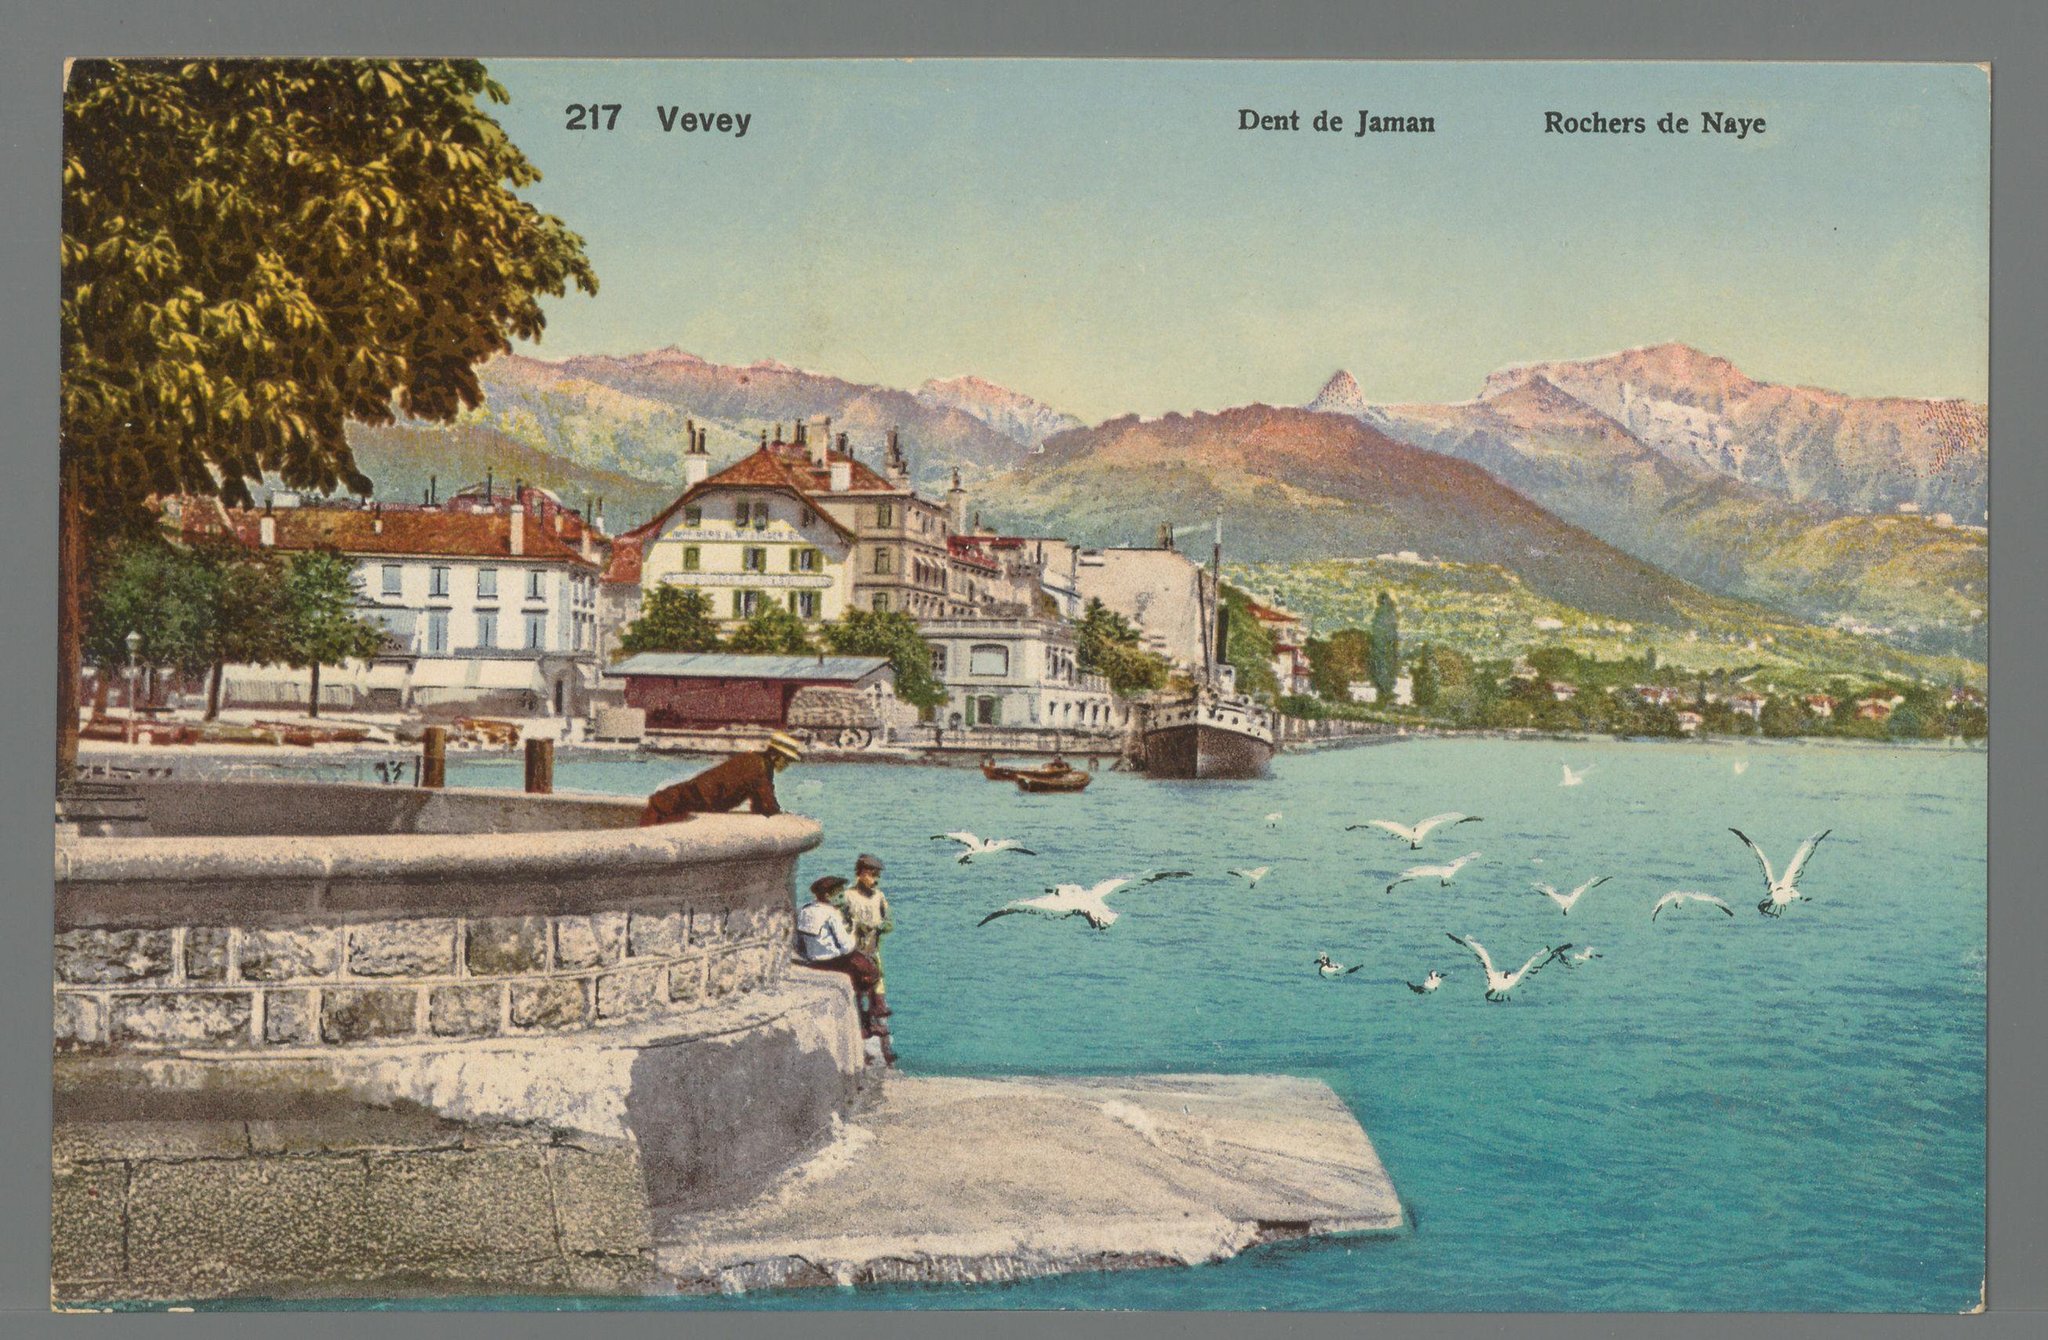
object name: photomechanical print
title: Vevey. Dent de Jaman. Rochers de Naye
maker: Anonymous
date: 1905-1920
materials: cardboard, photographic process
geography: vevey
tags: lake, mountain-range, snow peaks, prospect of city, town panorama, silhouette of city